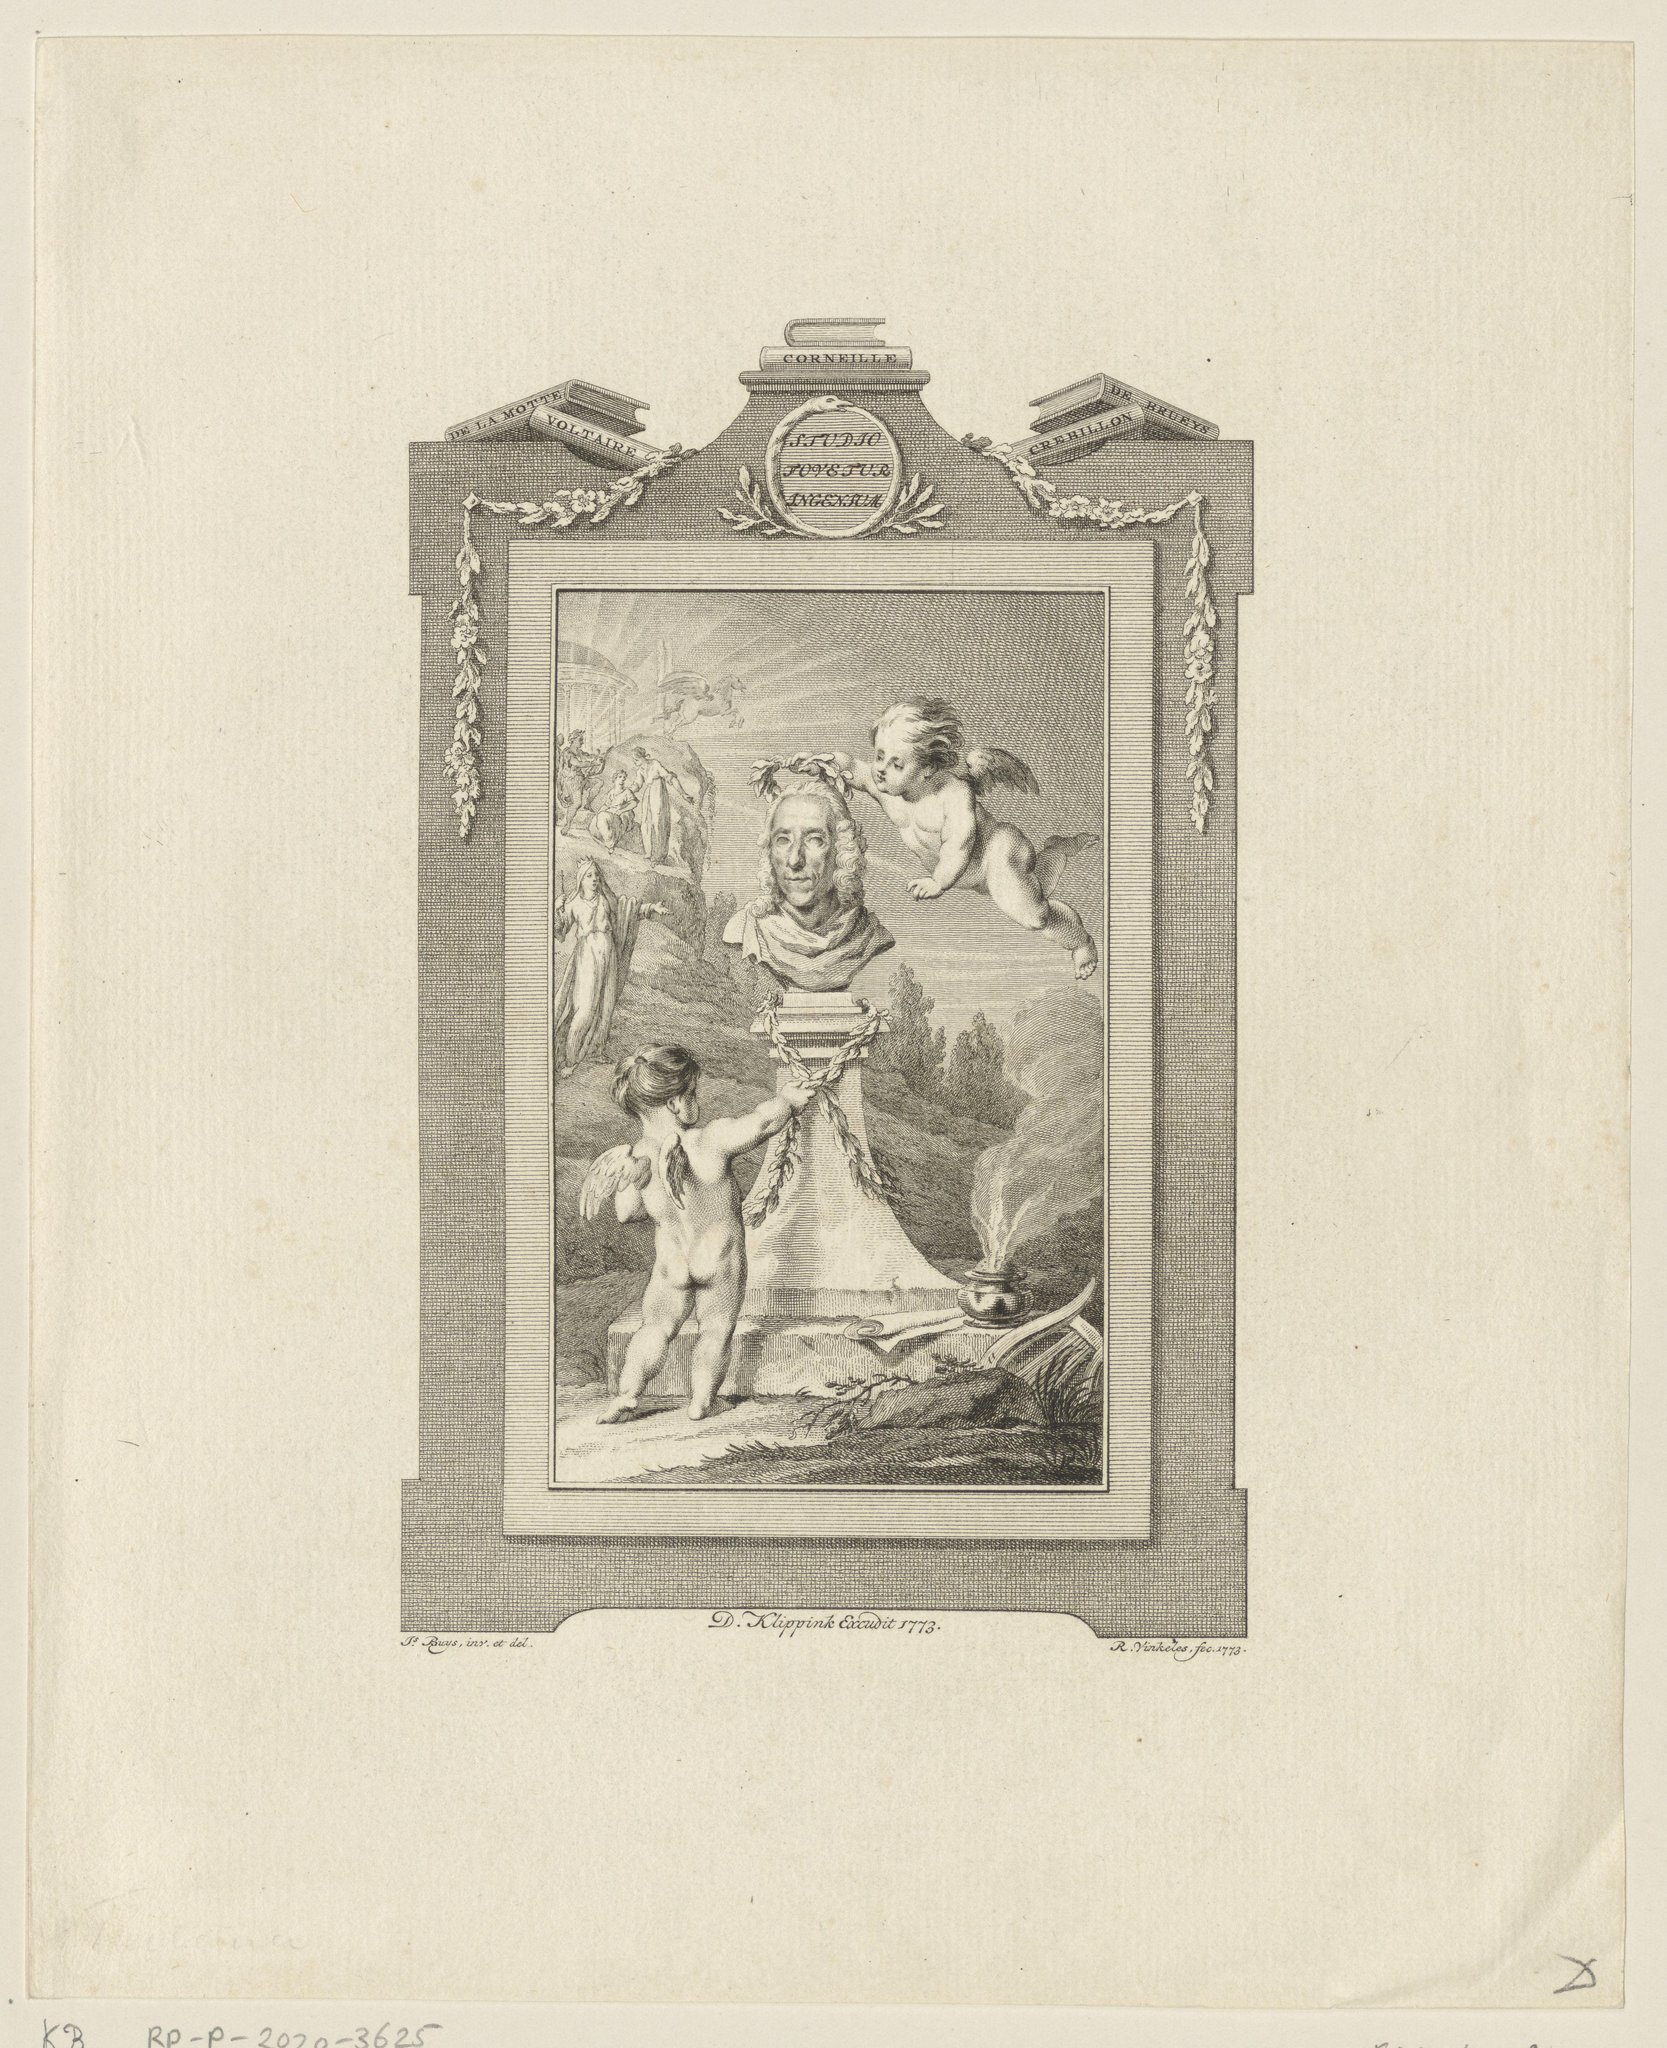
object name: print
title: Allegorische voorstelling met borstbeeld van Sybrand Feitama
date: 1773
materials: paper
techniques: engraving, etching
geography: amsterdam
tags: draughtsman, sybrand feitama (ii), honouring the artist with laurel wreath, historical persons, parnassus, sacred to apollo musagetes, book, cupids: 'amores', 'amoretti', 'putti', smoking pot as symbol of 'vanitas'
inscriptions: collector's mark: Lugt 240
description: Twee putti lauweren het borstbeeld van de kunstenaar Sybrand Feitama, dat op een sokkel staat. Op de grond staat een rokende pot, dat symbool staat voor zijn overlijden. Ook ligt er een lier en een rol papier. Links Apollo, de muzen en Pegasus op de Parnassus. Bovenaan op de omlijsting boeken en het eeuwigheidssymbool de Ouroboros.